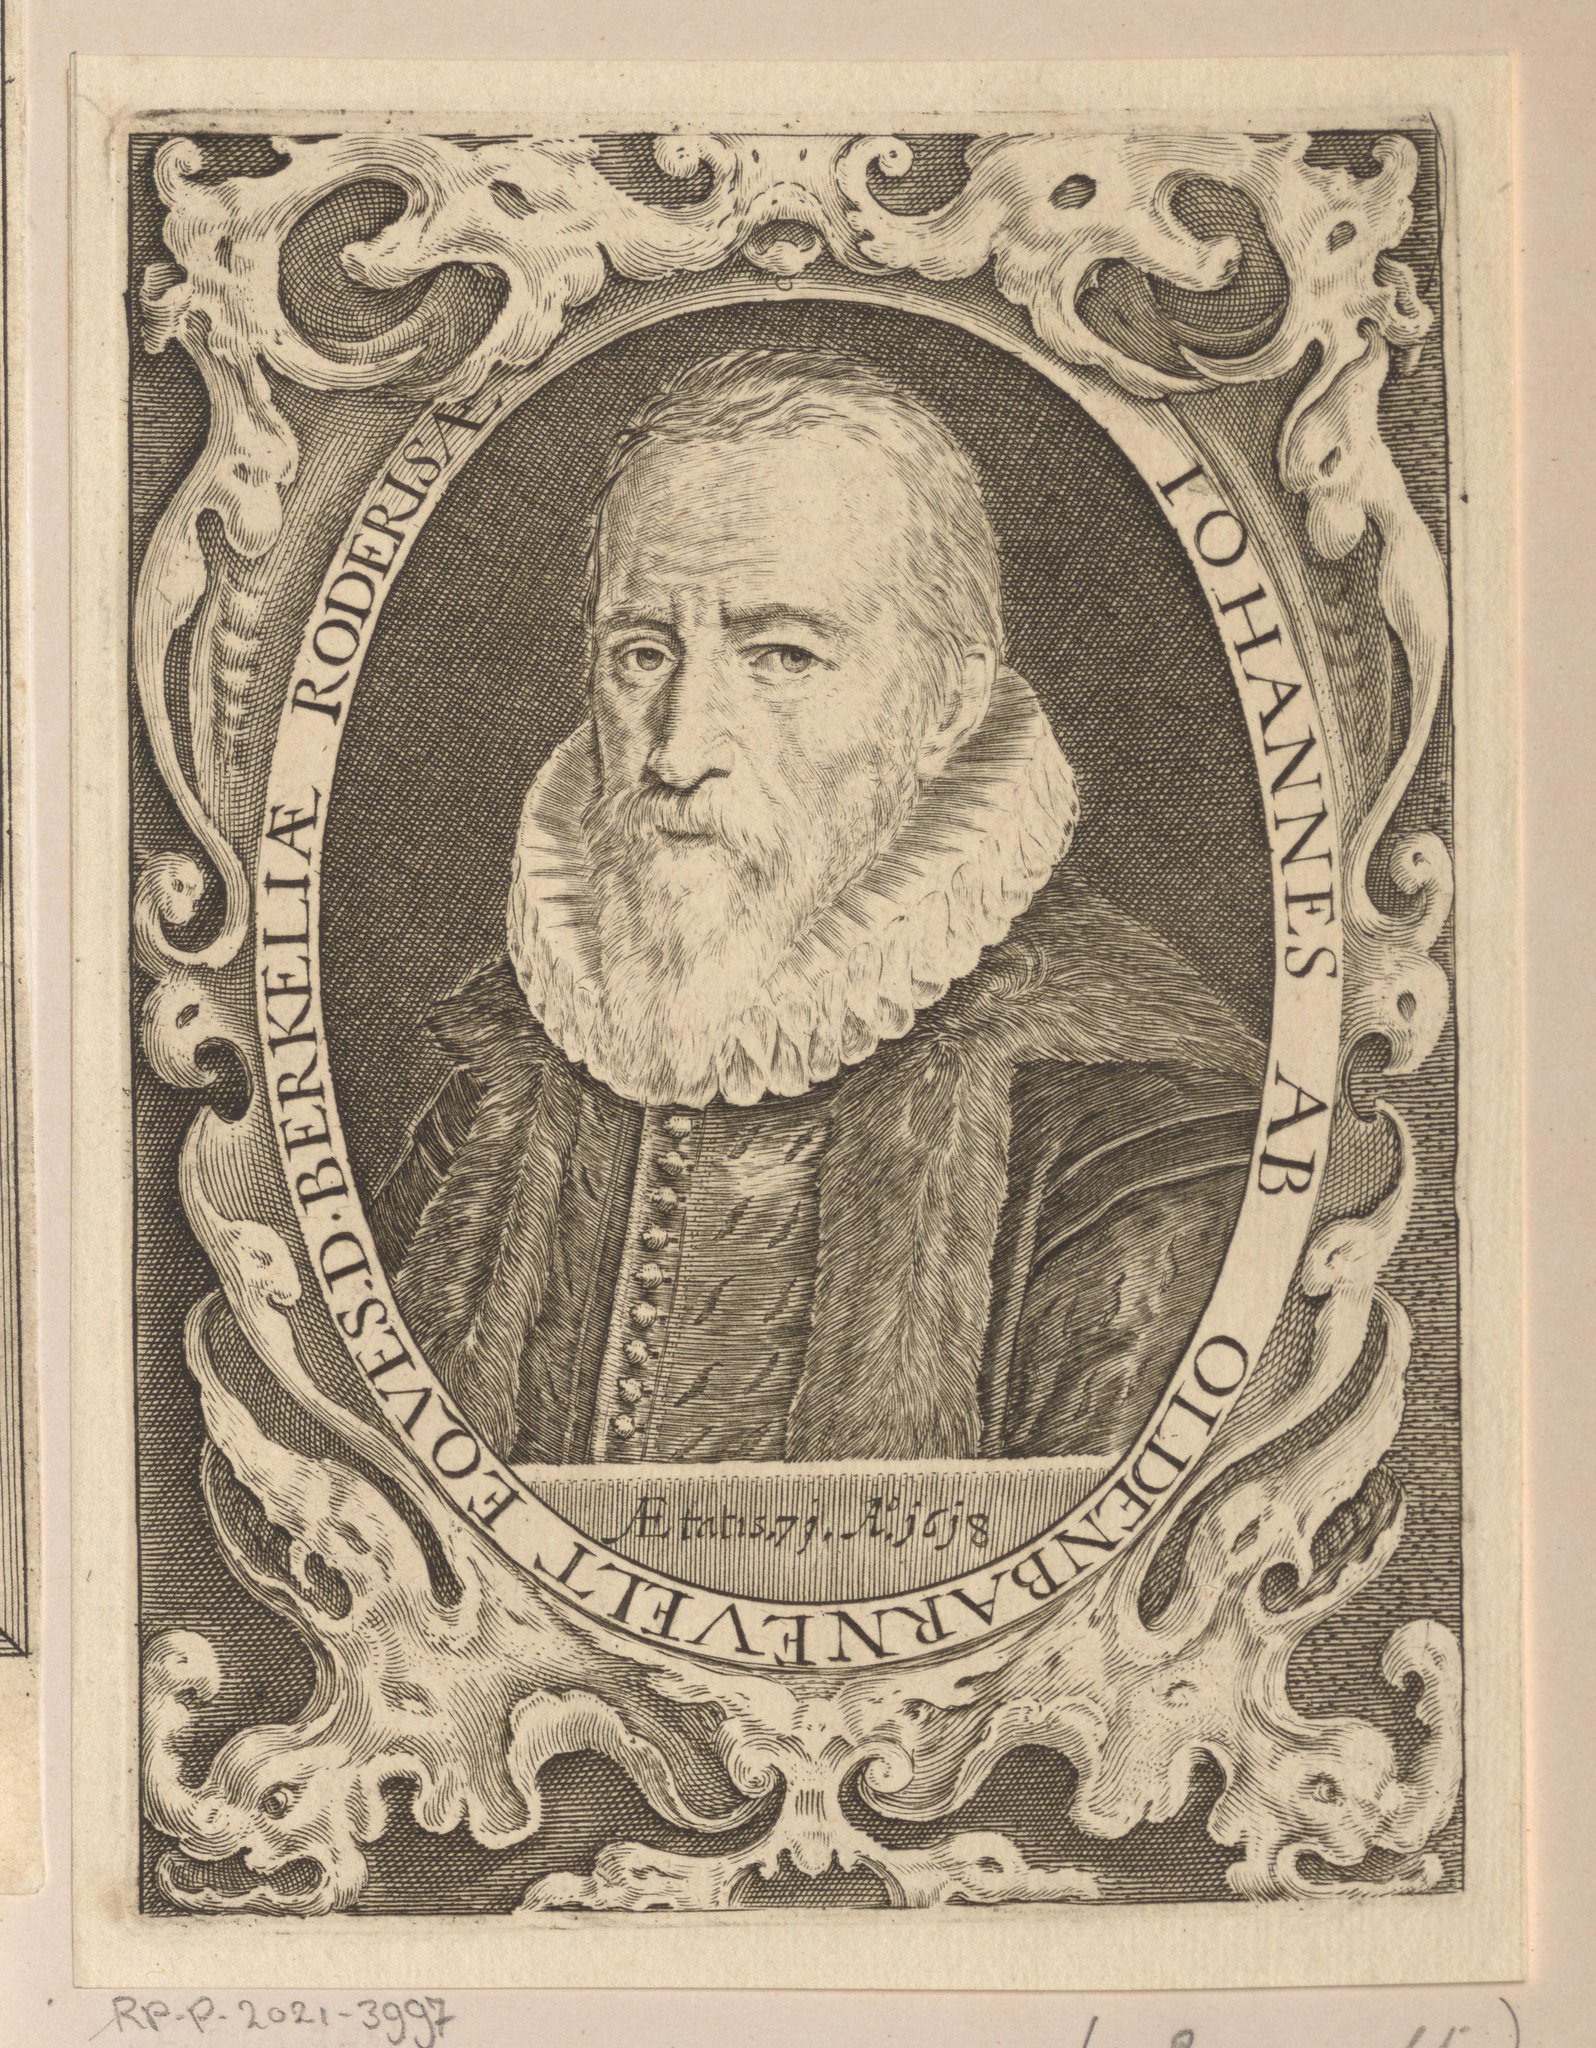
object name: print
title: Portret van Johan van Oldenbarnevelt op 71-jarige leeftijd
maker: renold elstrack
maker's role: print maker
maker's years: 1571-1625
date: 1618-1625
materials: paper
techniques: engraving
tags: the hague, johan van oldenbarnevelt, historical persons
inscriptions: collector's mark: Lugt 240